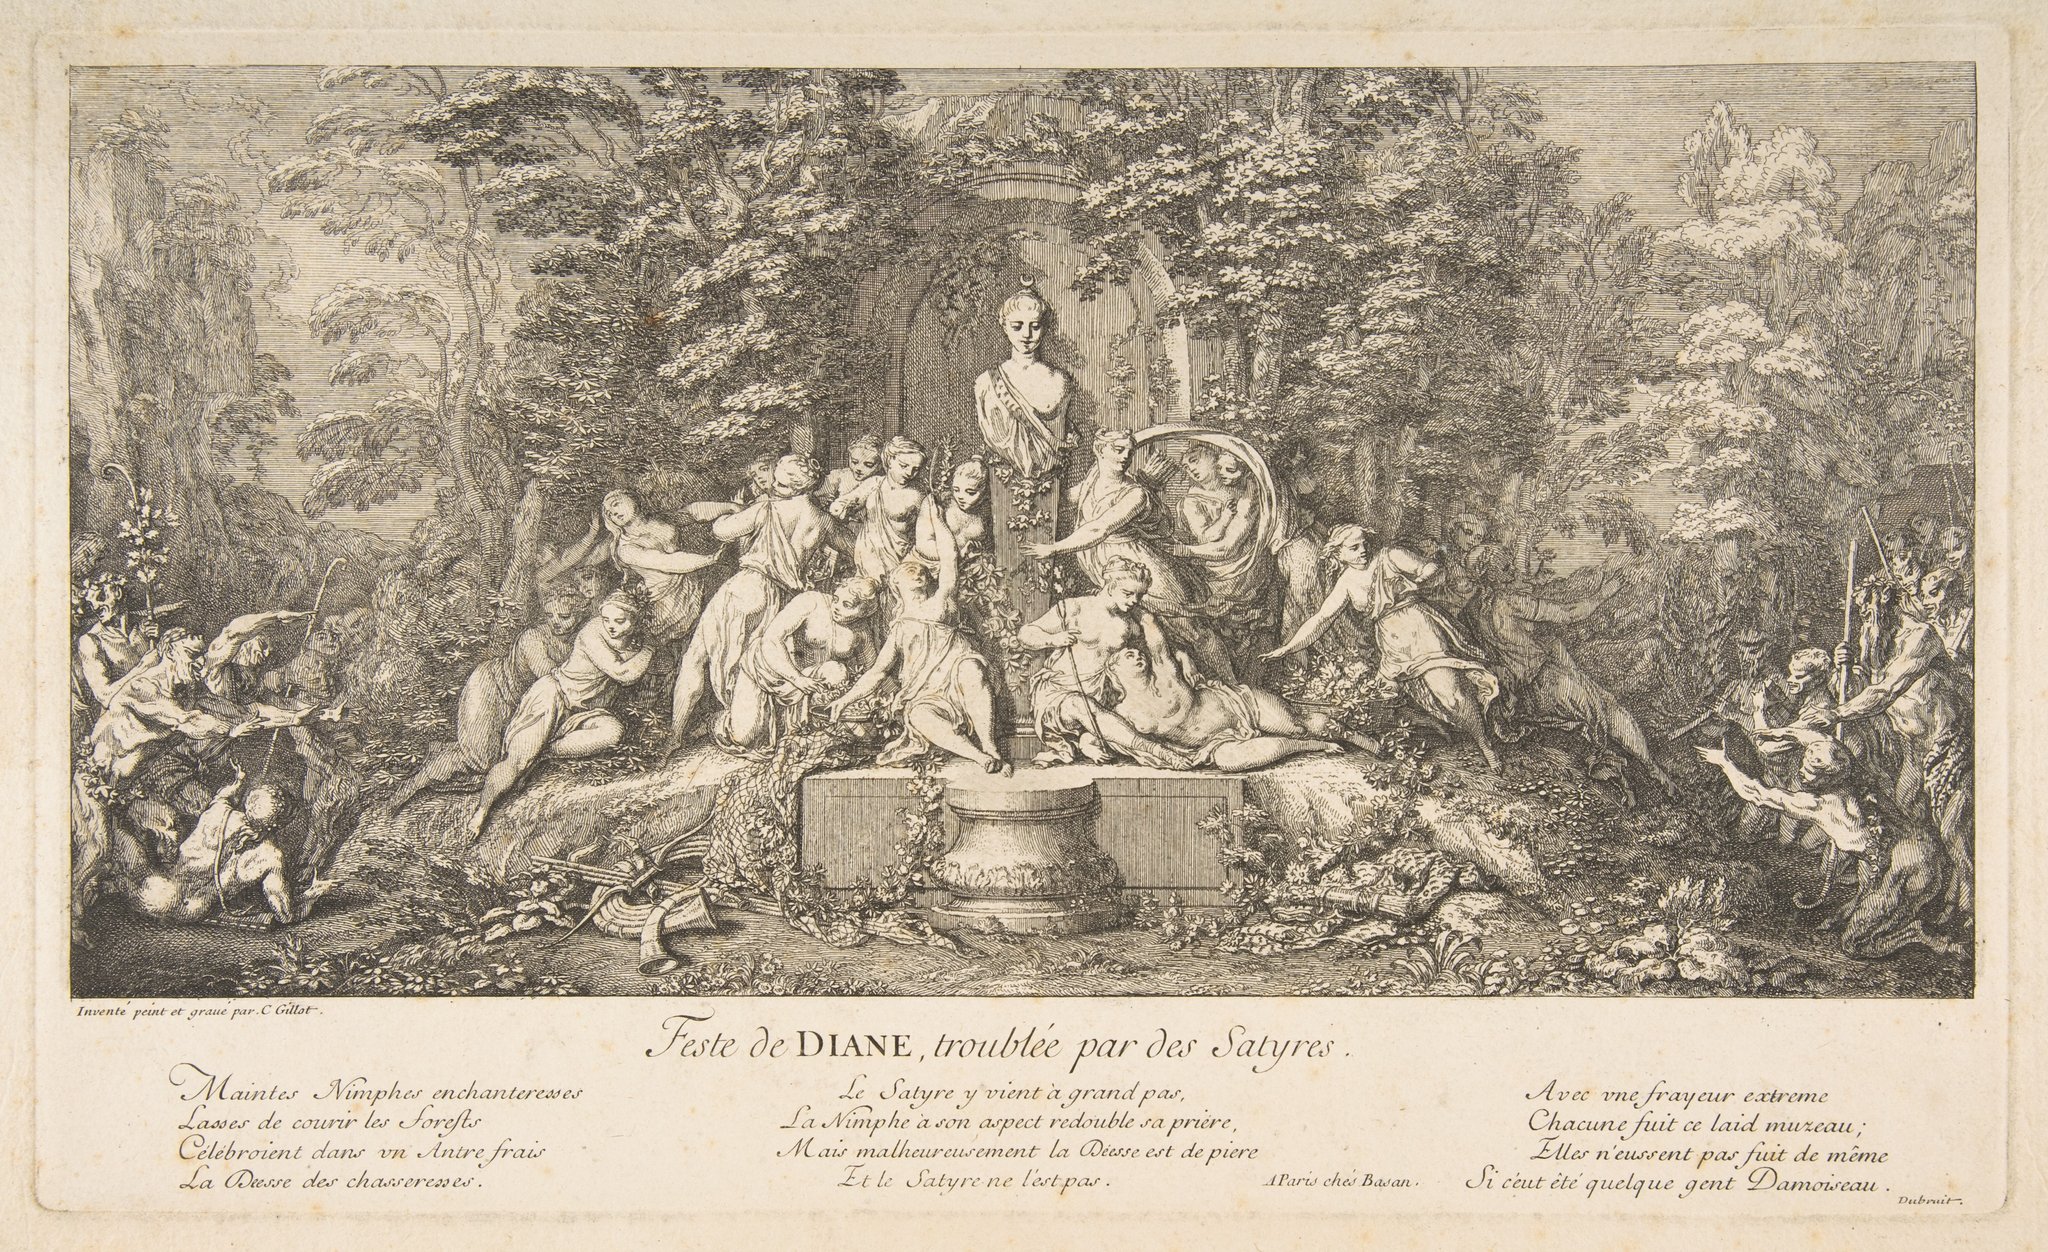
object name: print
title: Feast of Diana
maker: claude gillot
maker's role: artist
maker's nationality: french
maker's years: 1673-1722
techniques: etching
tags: female nudes,diana